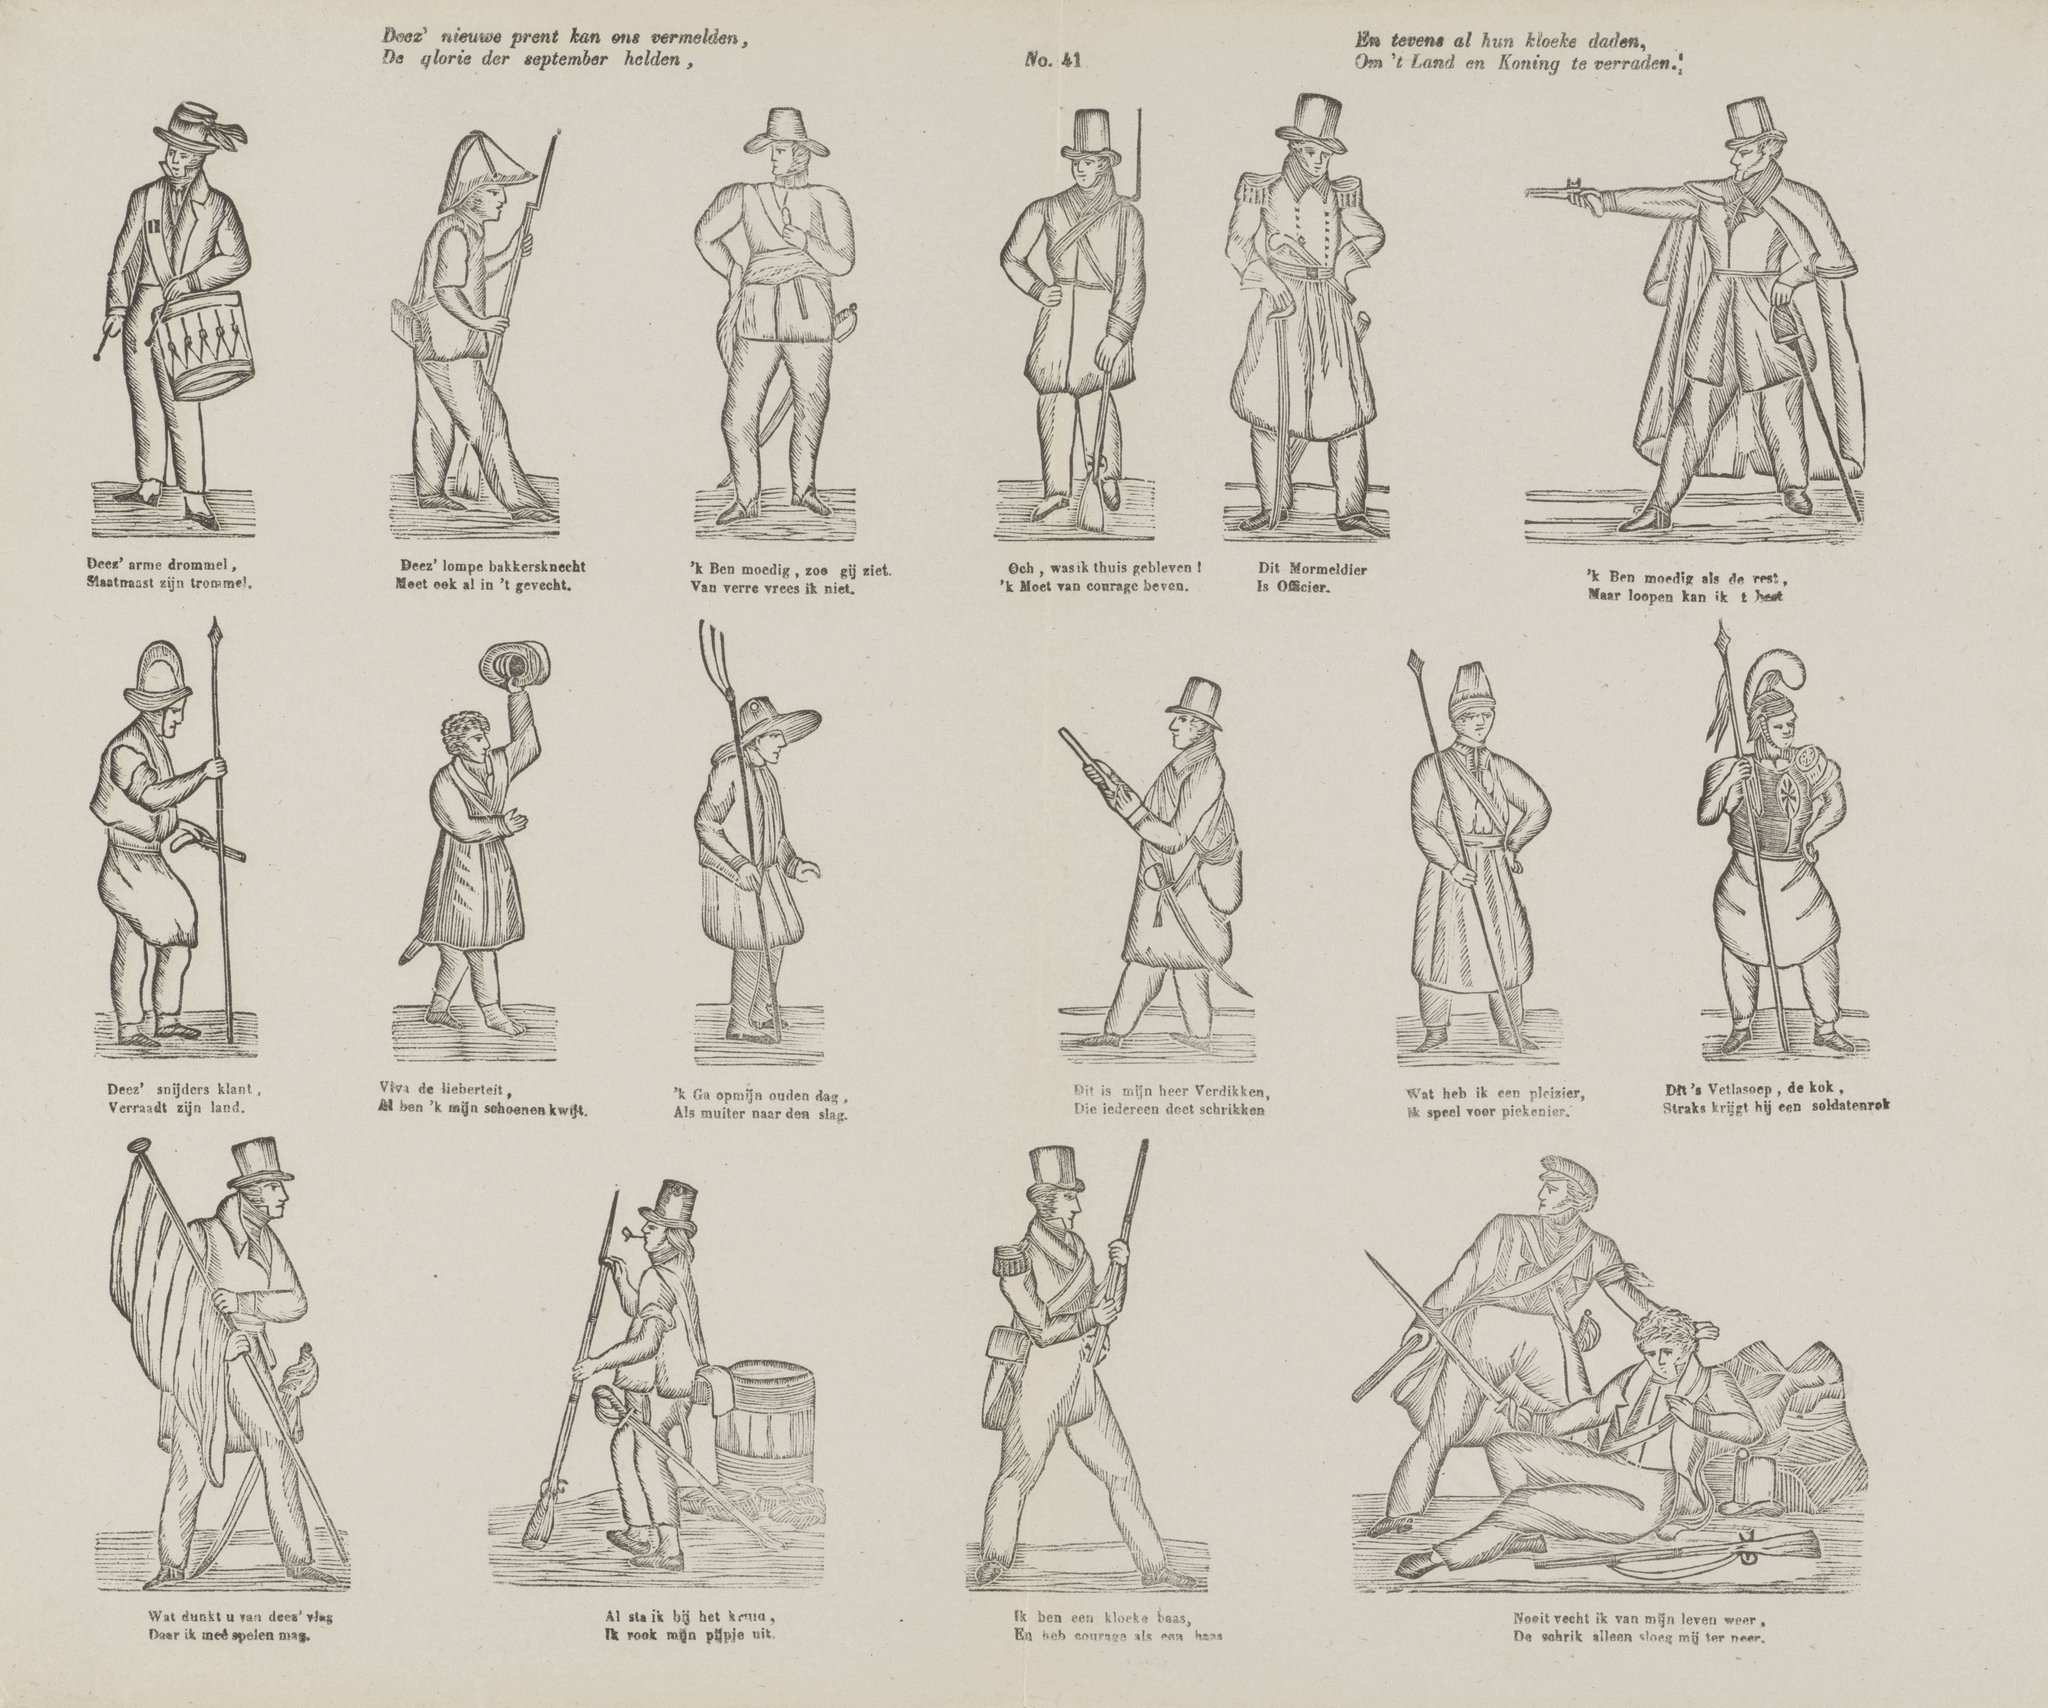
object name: popular print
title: Deeze, nieuwe prent kan ons vermelden, / De glorie der september helden, / En tevens al hun kloeke daden, / Om 't land en koning te verraden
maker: Anonymous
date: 1848-1881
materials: paper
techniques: letterpress printing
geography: den bosch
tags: the soldier; the soldier's life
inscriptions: collector's mark: Lugt 2760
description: Blad met 16 voorstellingen van militairen. Onder elke afbeelding een tweeregelig vers. Genummerd midden boven: No. 41.